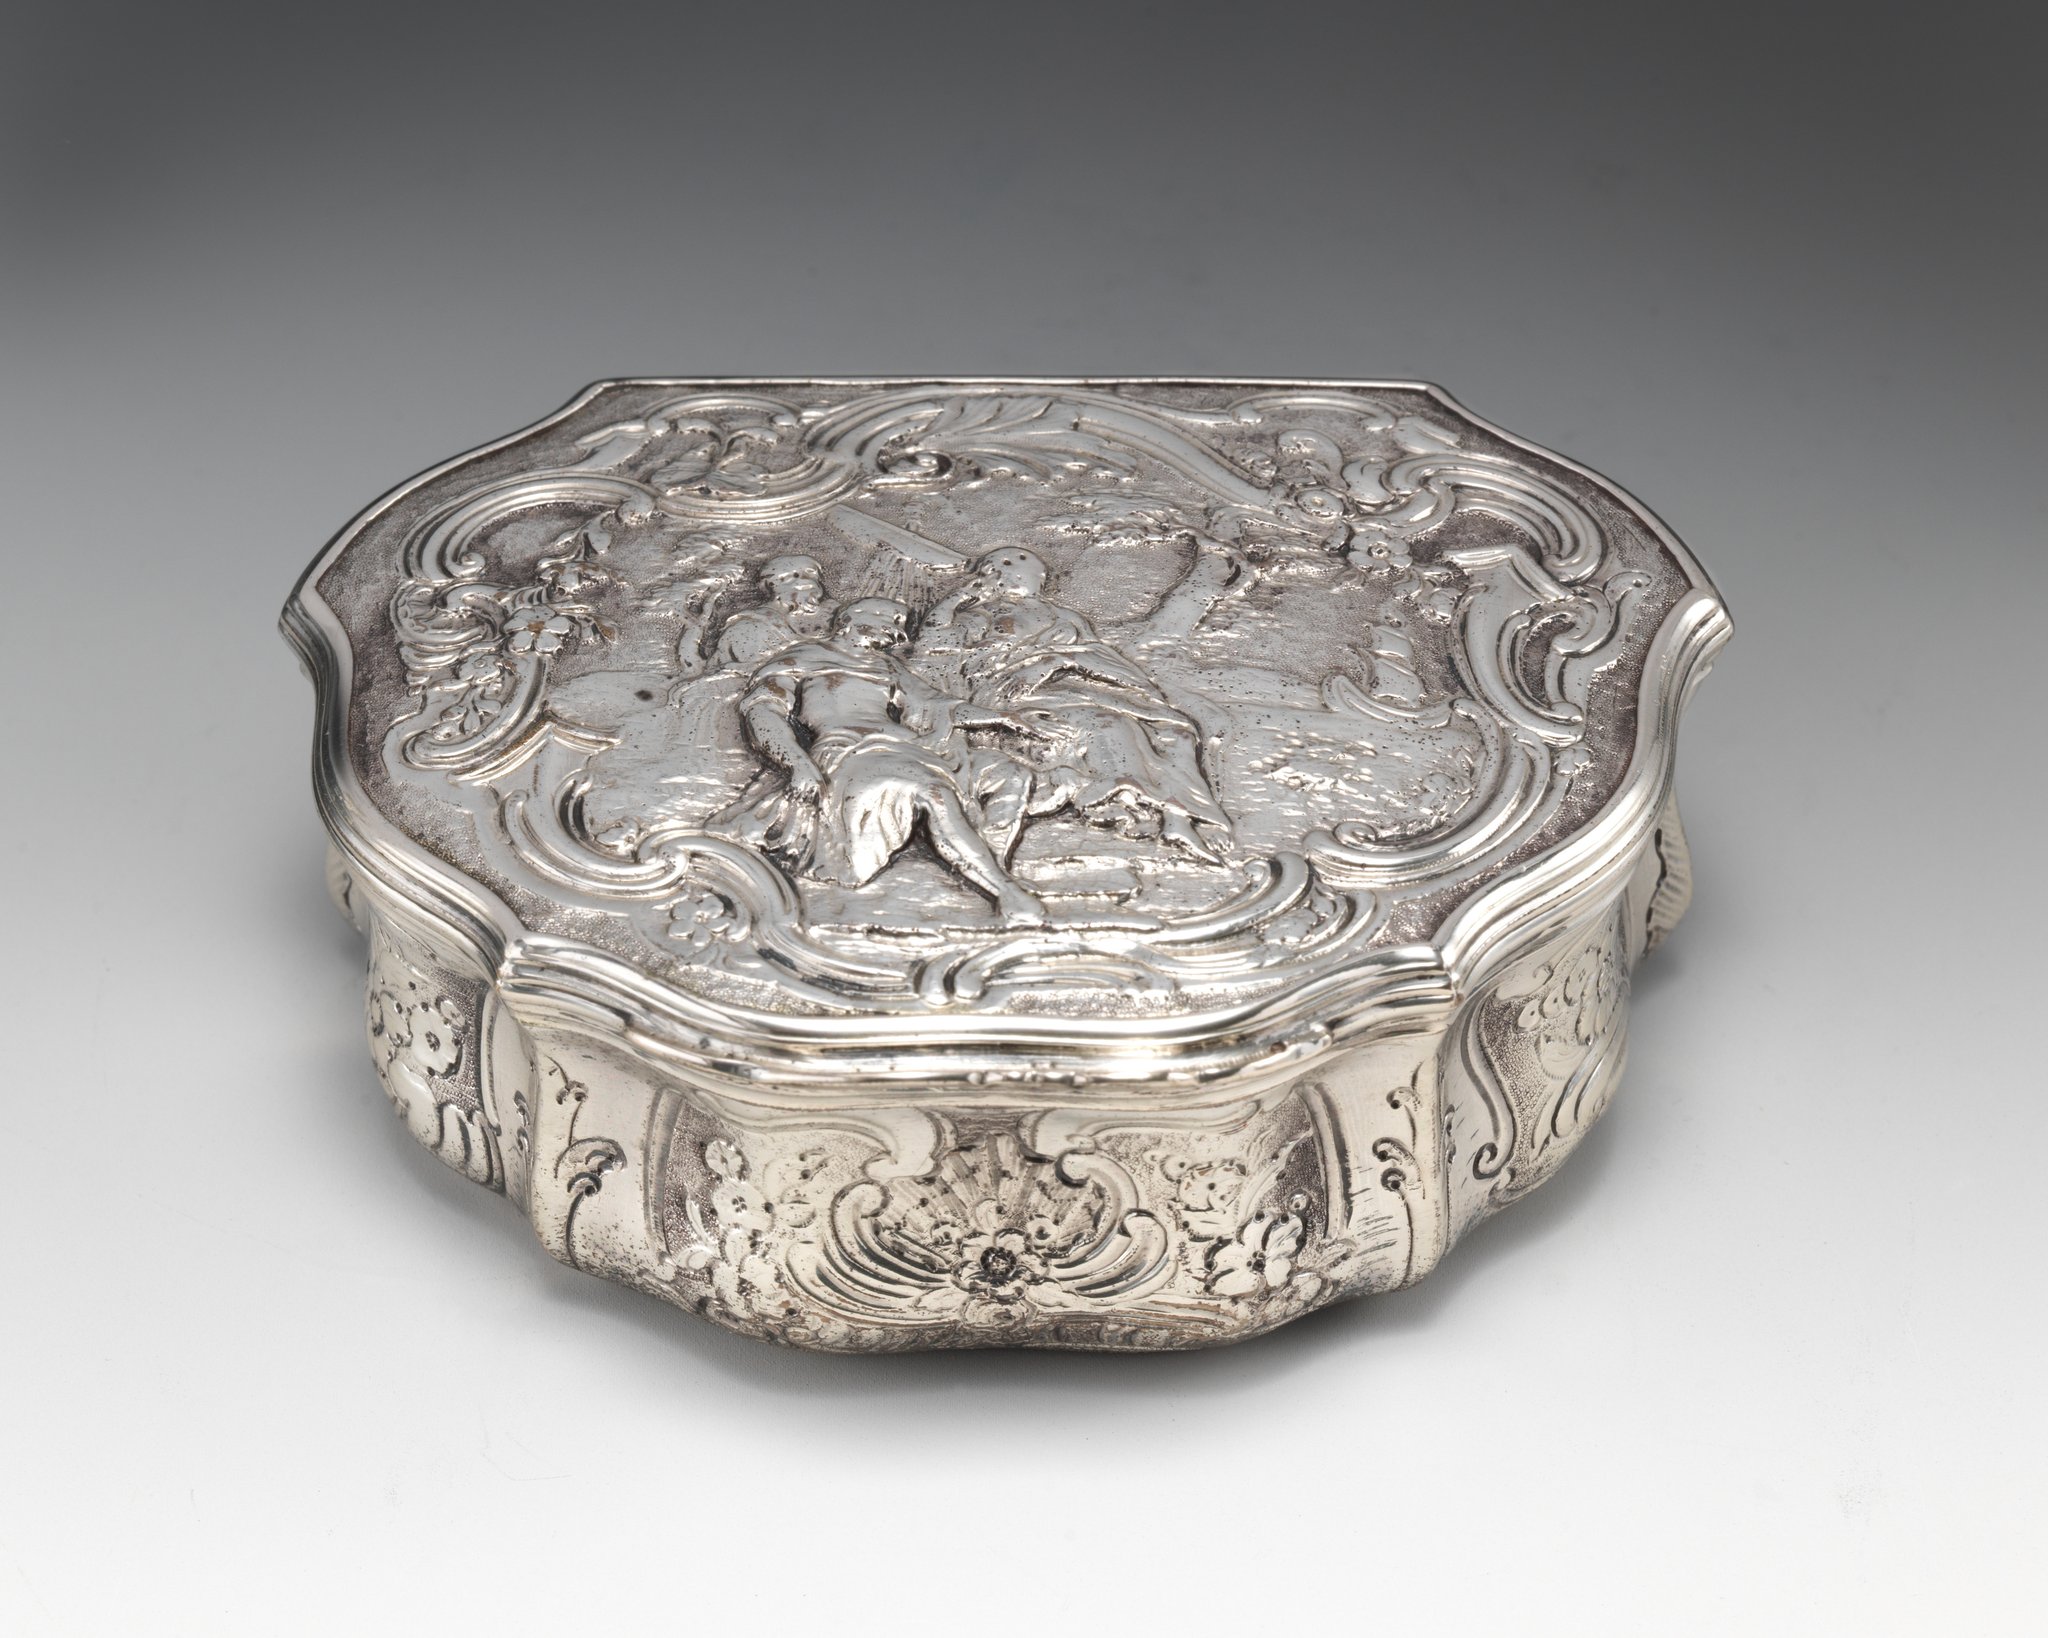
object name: box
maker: g. d., london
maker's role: maker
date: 1749-1750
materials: gilt, silver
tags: human figures